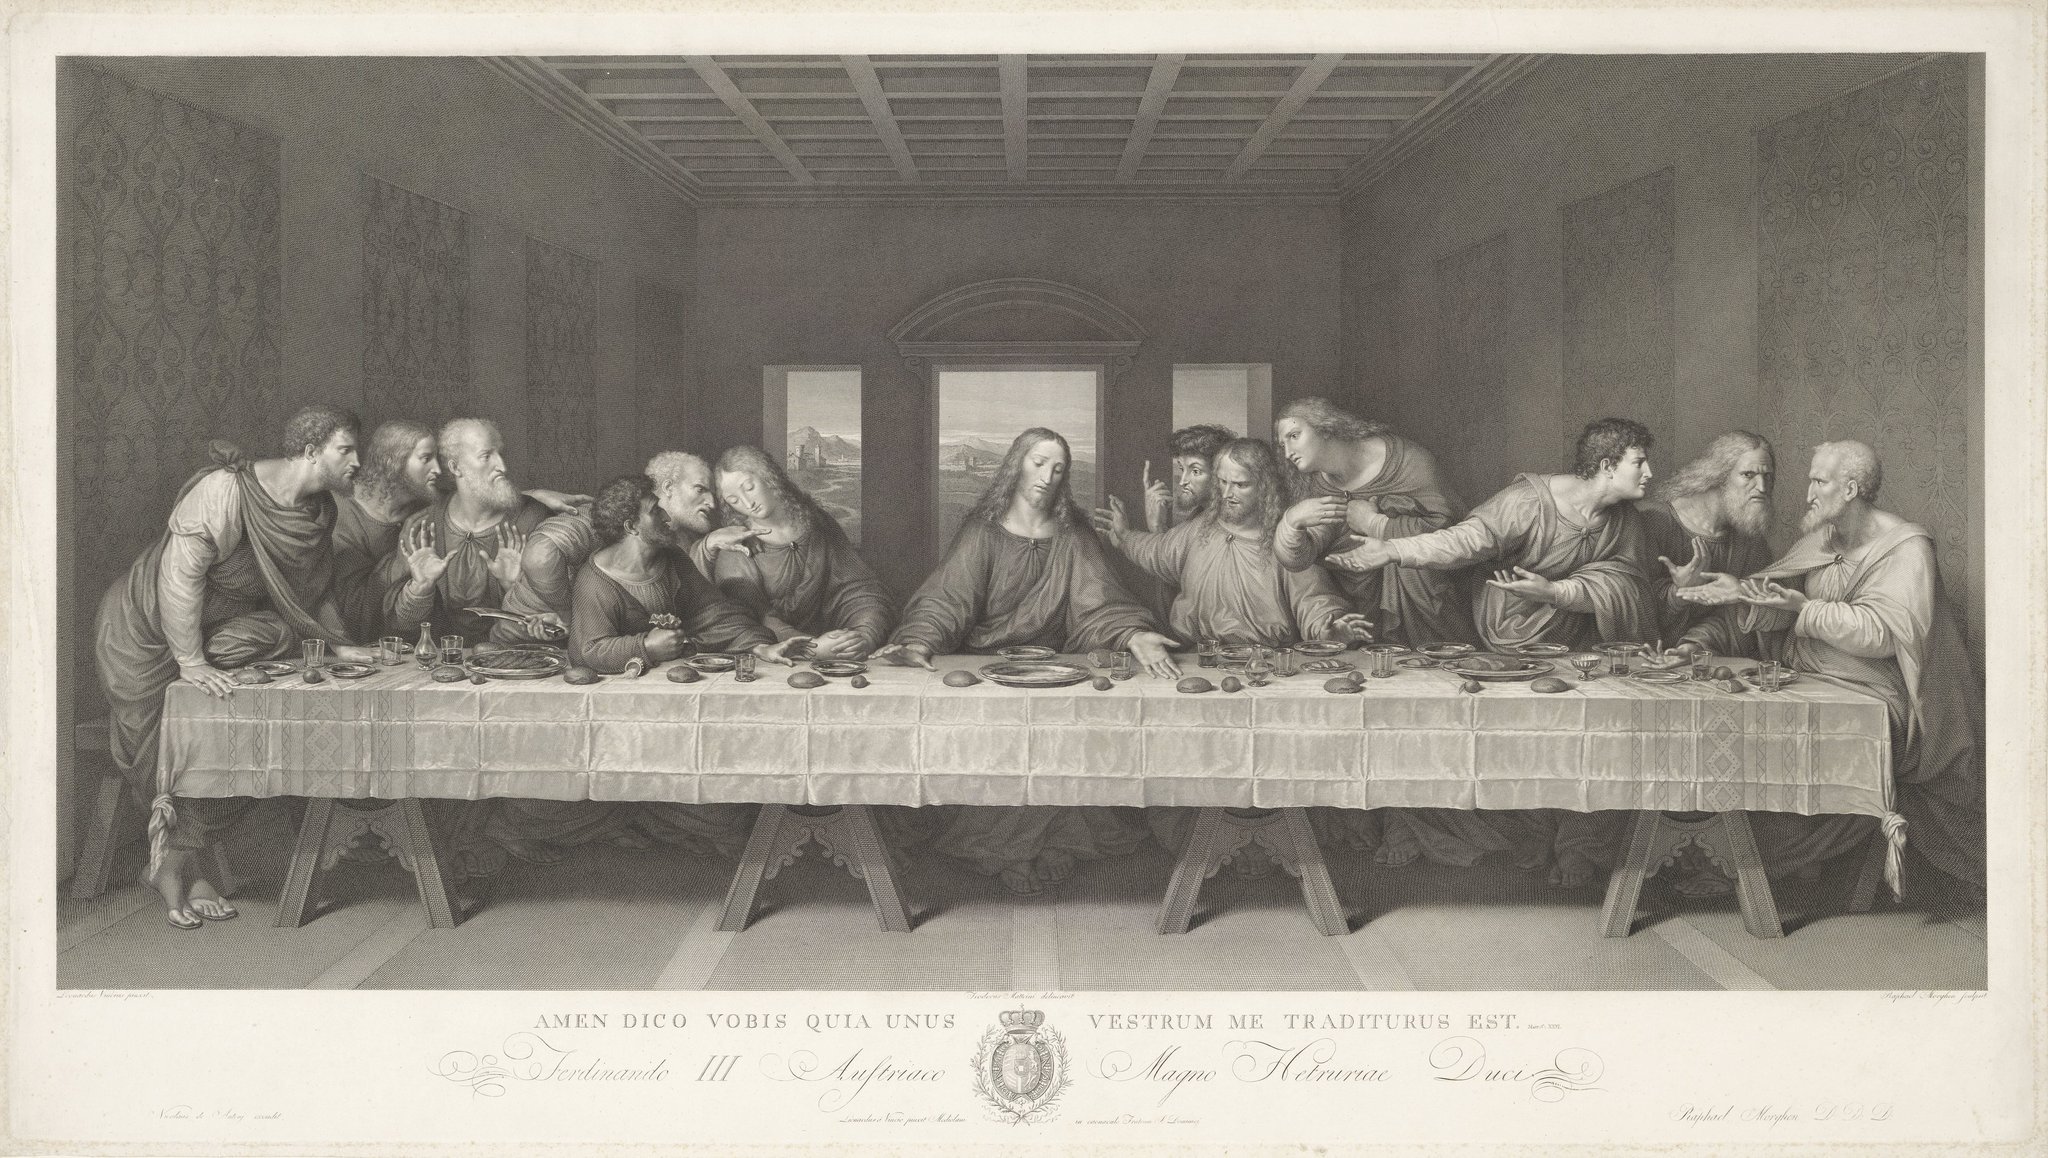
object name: print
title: Het laatste avondmaal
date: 1768-1833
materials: paper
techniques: engraving, etching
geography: milan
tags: last supper (in general) (matthew 26:21-35; mark 14:18-31; luke 22:3, 22:15-23; john 13:21-38)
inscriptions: collector's mark: Lugt 12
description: Het fresco 'Het laatste avondmaal' door Leonardo Da Vinci met Christus tussen de apostelen aan een lange tafel. Bijbelverwijzing en opdracht in ondermarge.